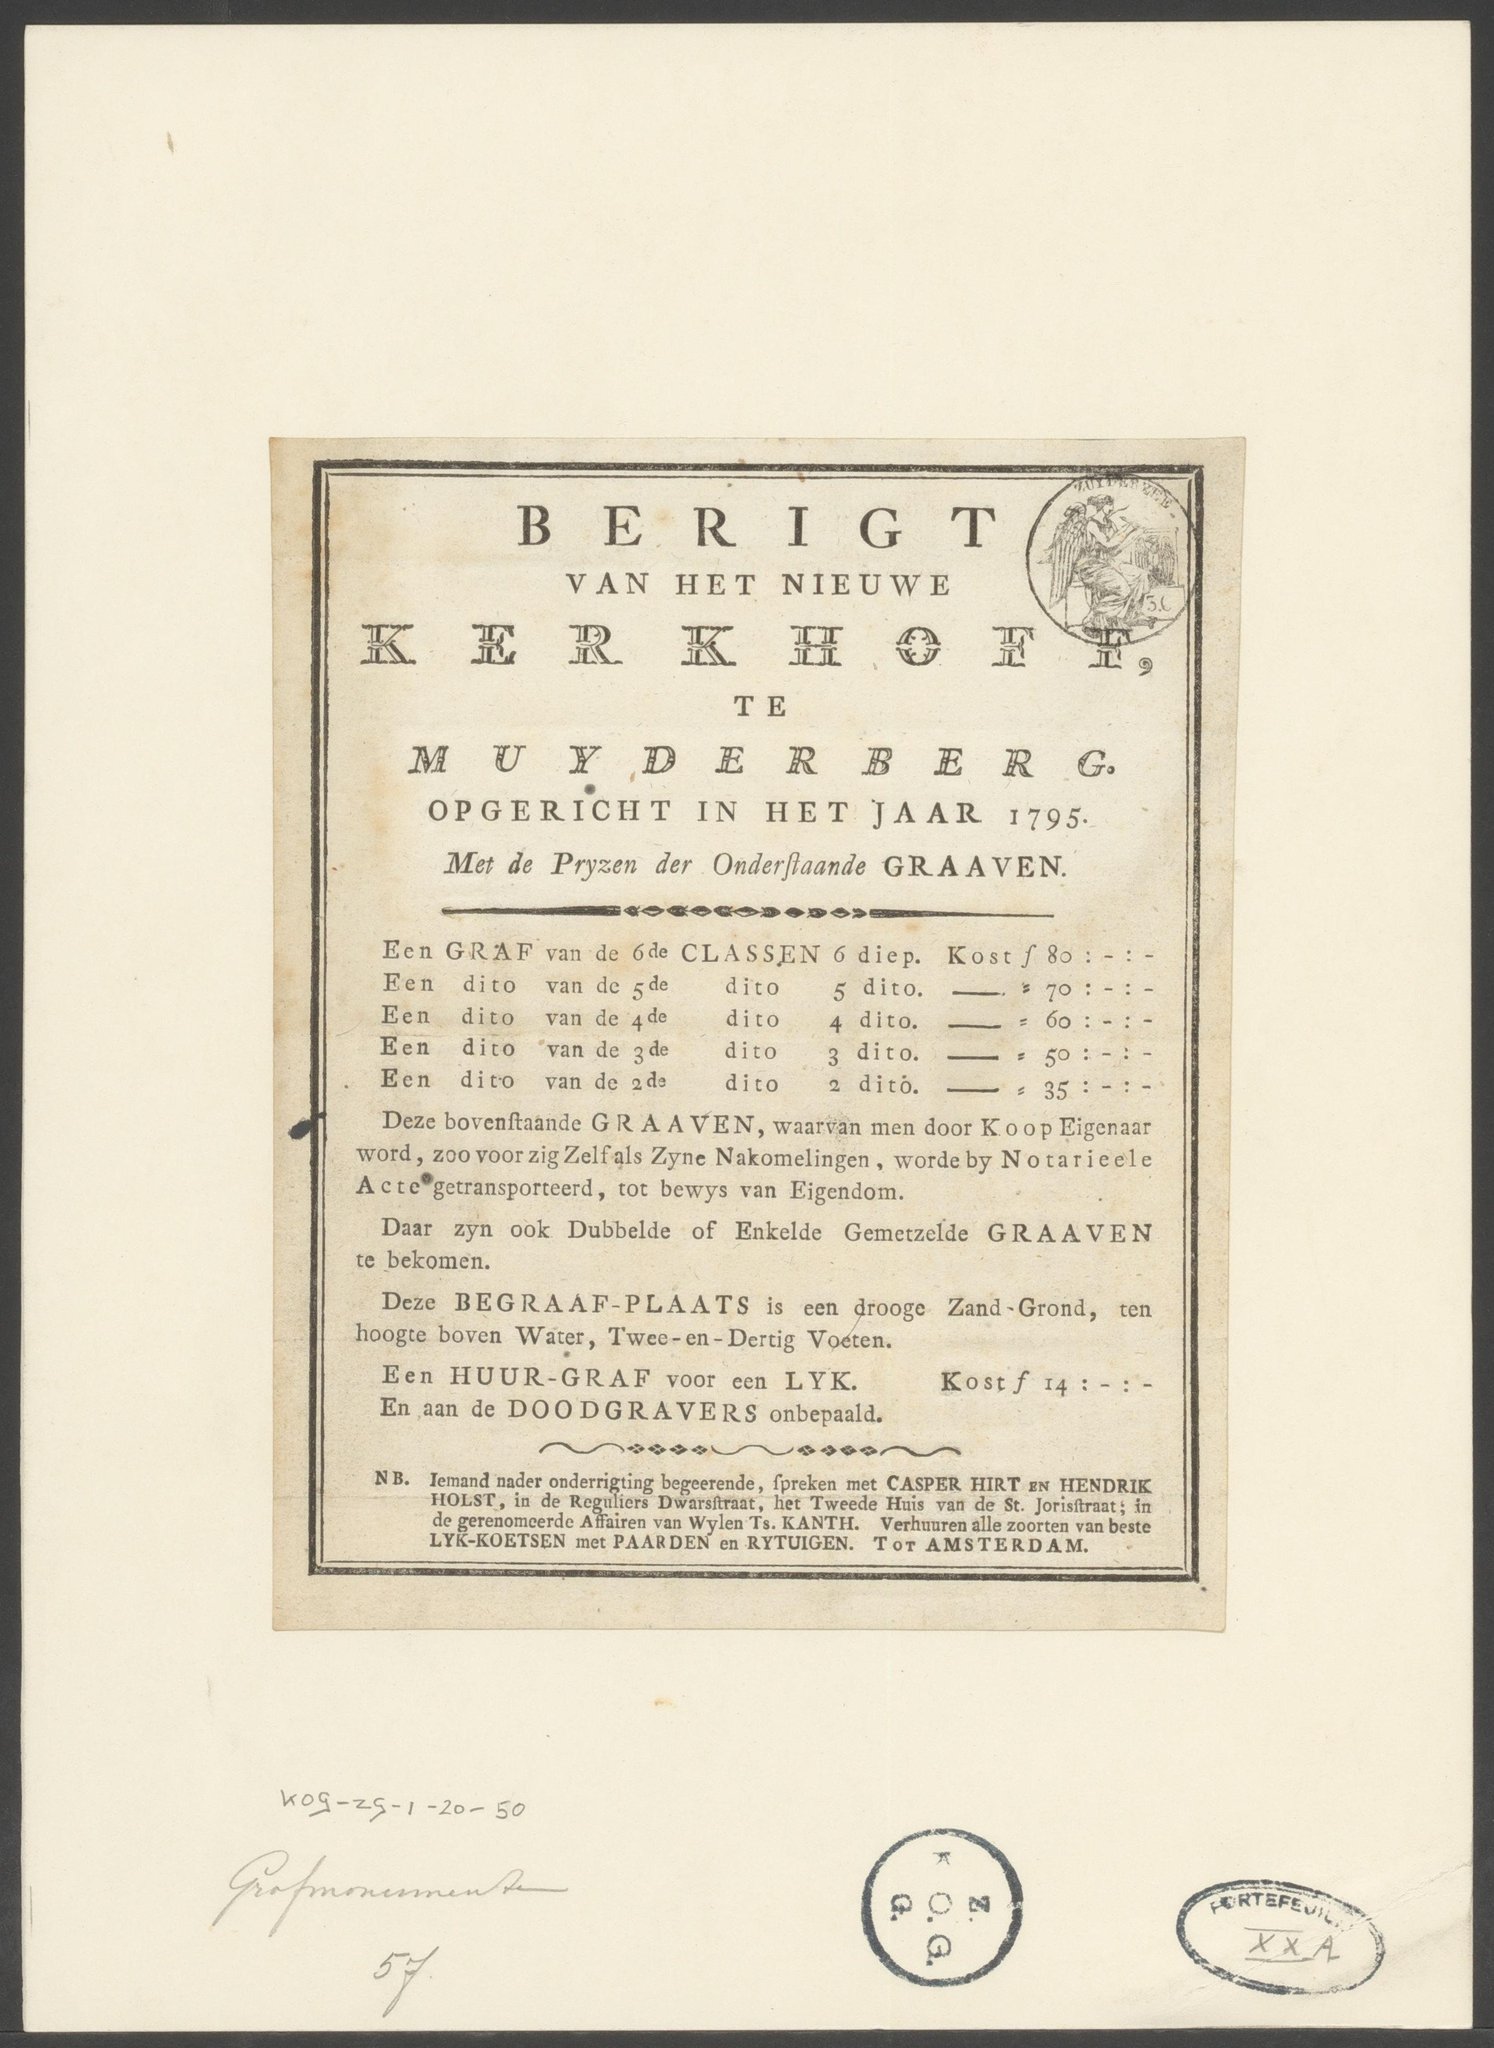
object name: text sheet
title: Berigt van het nieuwe kerkhof, te Muyderberg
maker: Anonymous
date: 1795-1800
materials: paper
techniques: letterpress printing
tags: churchyard, cemetery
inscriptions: collector's mark: Lugt 1641, stamp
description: Onderwerpsrubrieken binnen de Atlas Zeden en Gewoonten: Zeden en Gewoonten in Engeren Zin, Des menschen beging, midden en einde, Grafmonumenten.